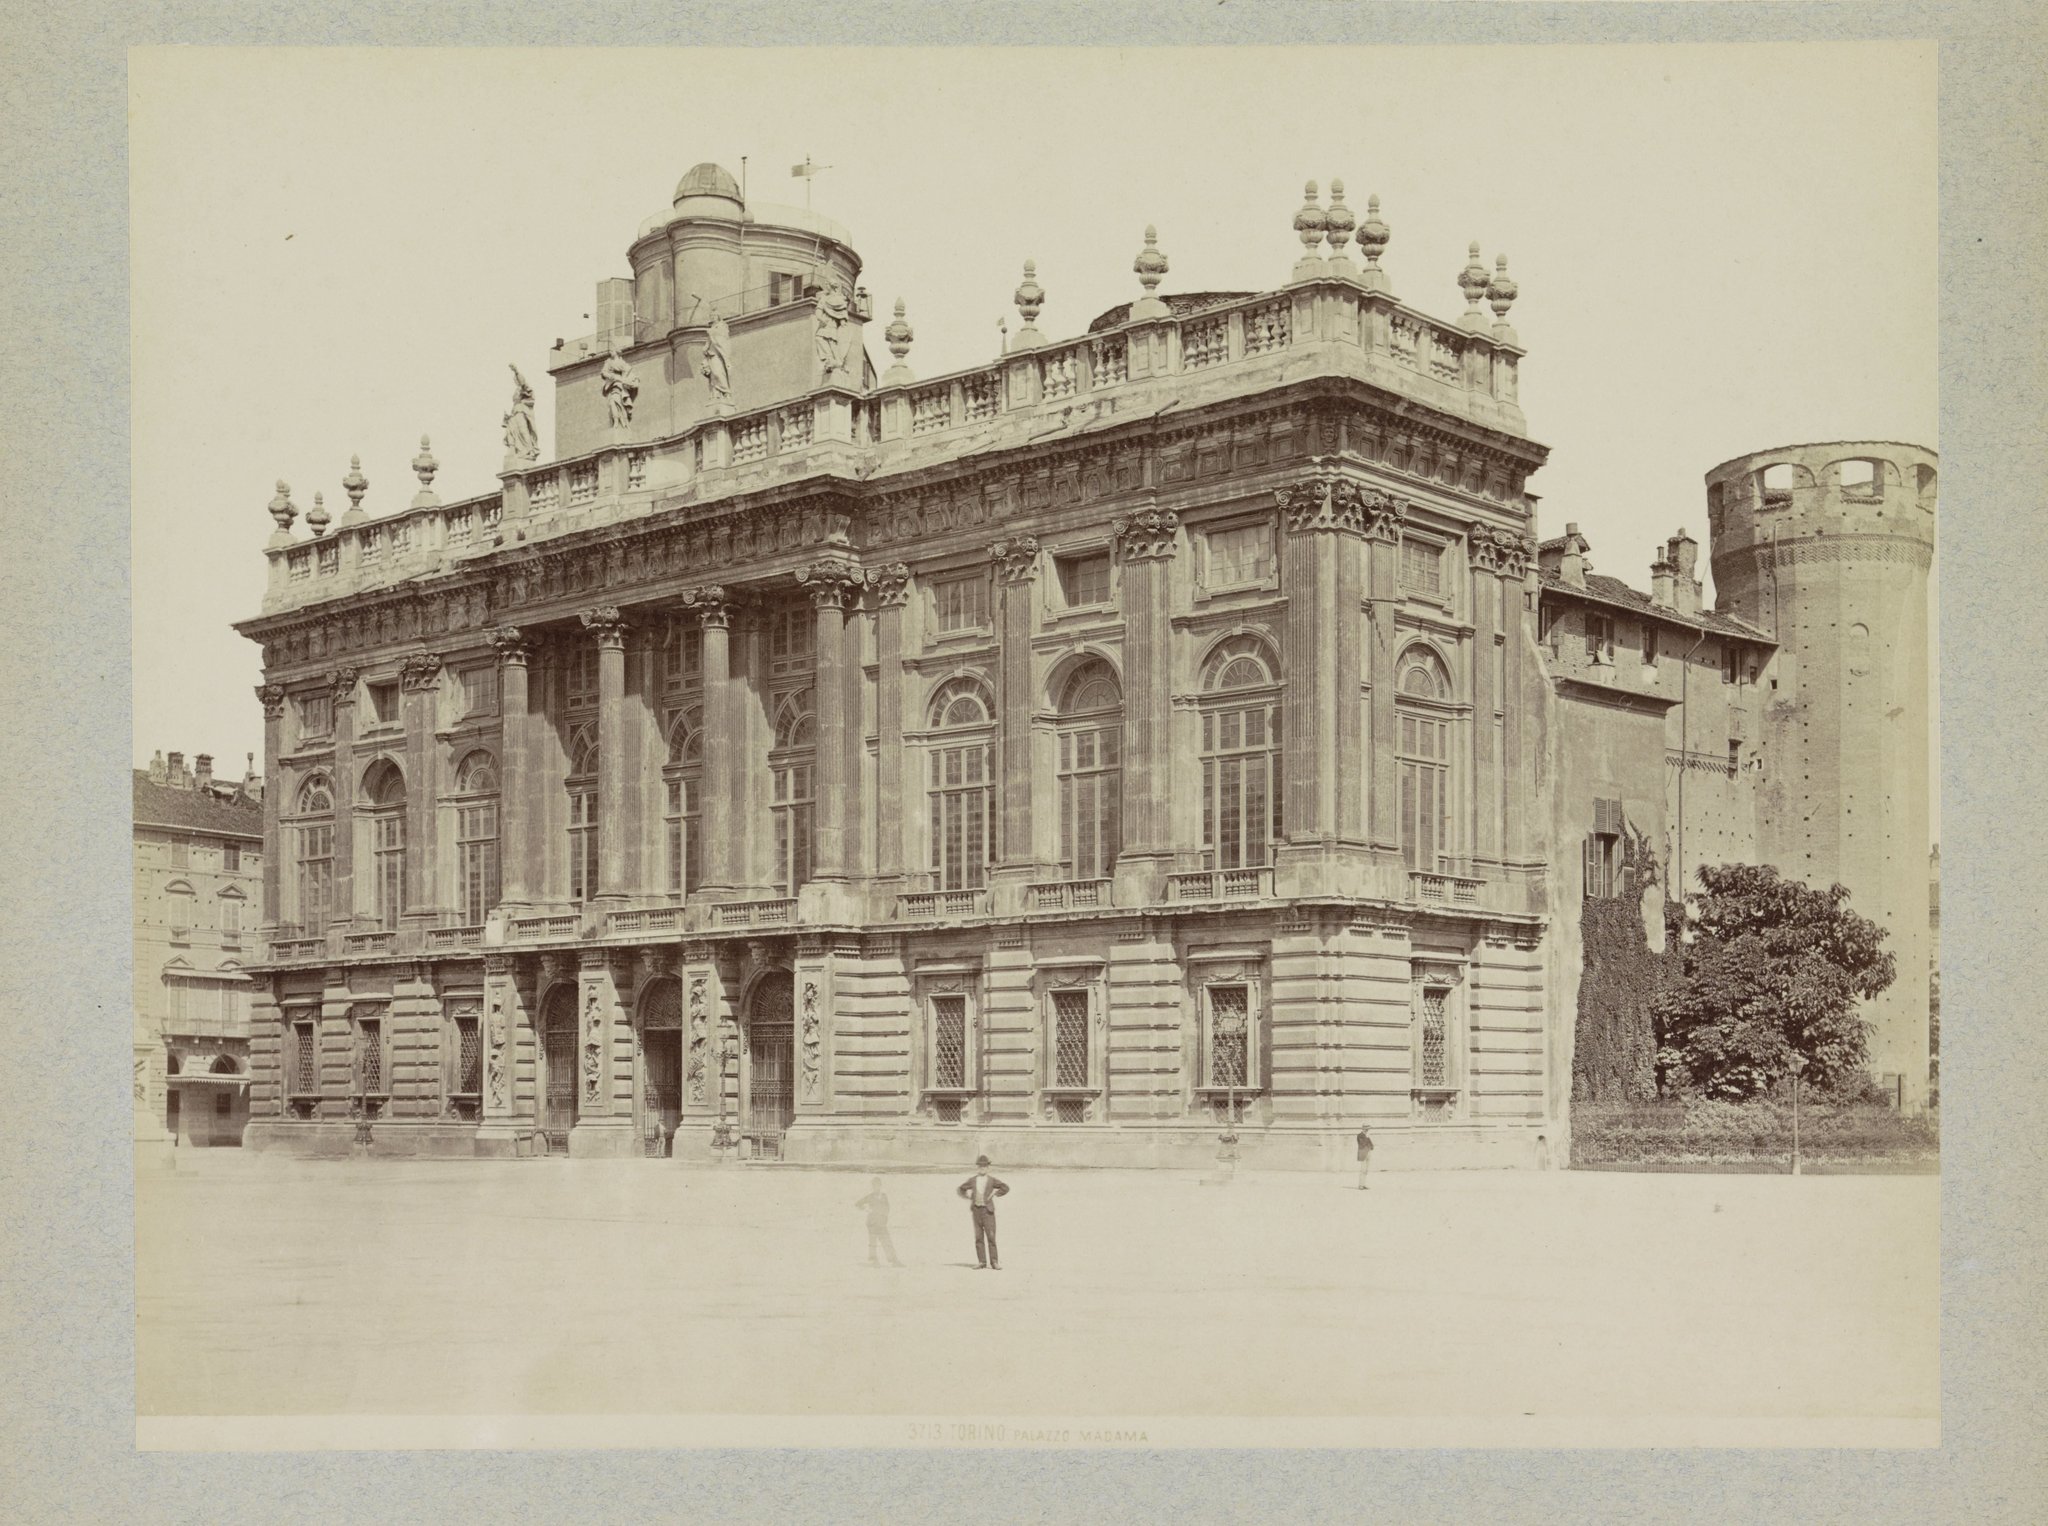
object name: photograph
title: 3713 Torinio Palazzo Madama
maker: Anonymous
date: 1885-1900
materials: paper, photographic support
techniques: albumen print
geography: palazzo madama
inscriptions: caption: ‘3713 Torinio Palazzo Madama’